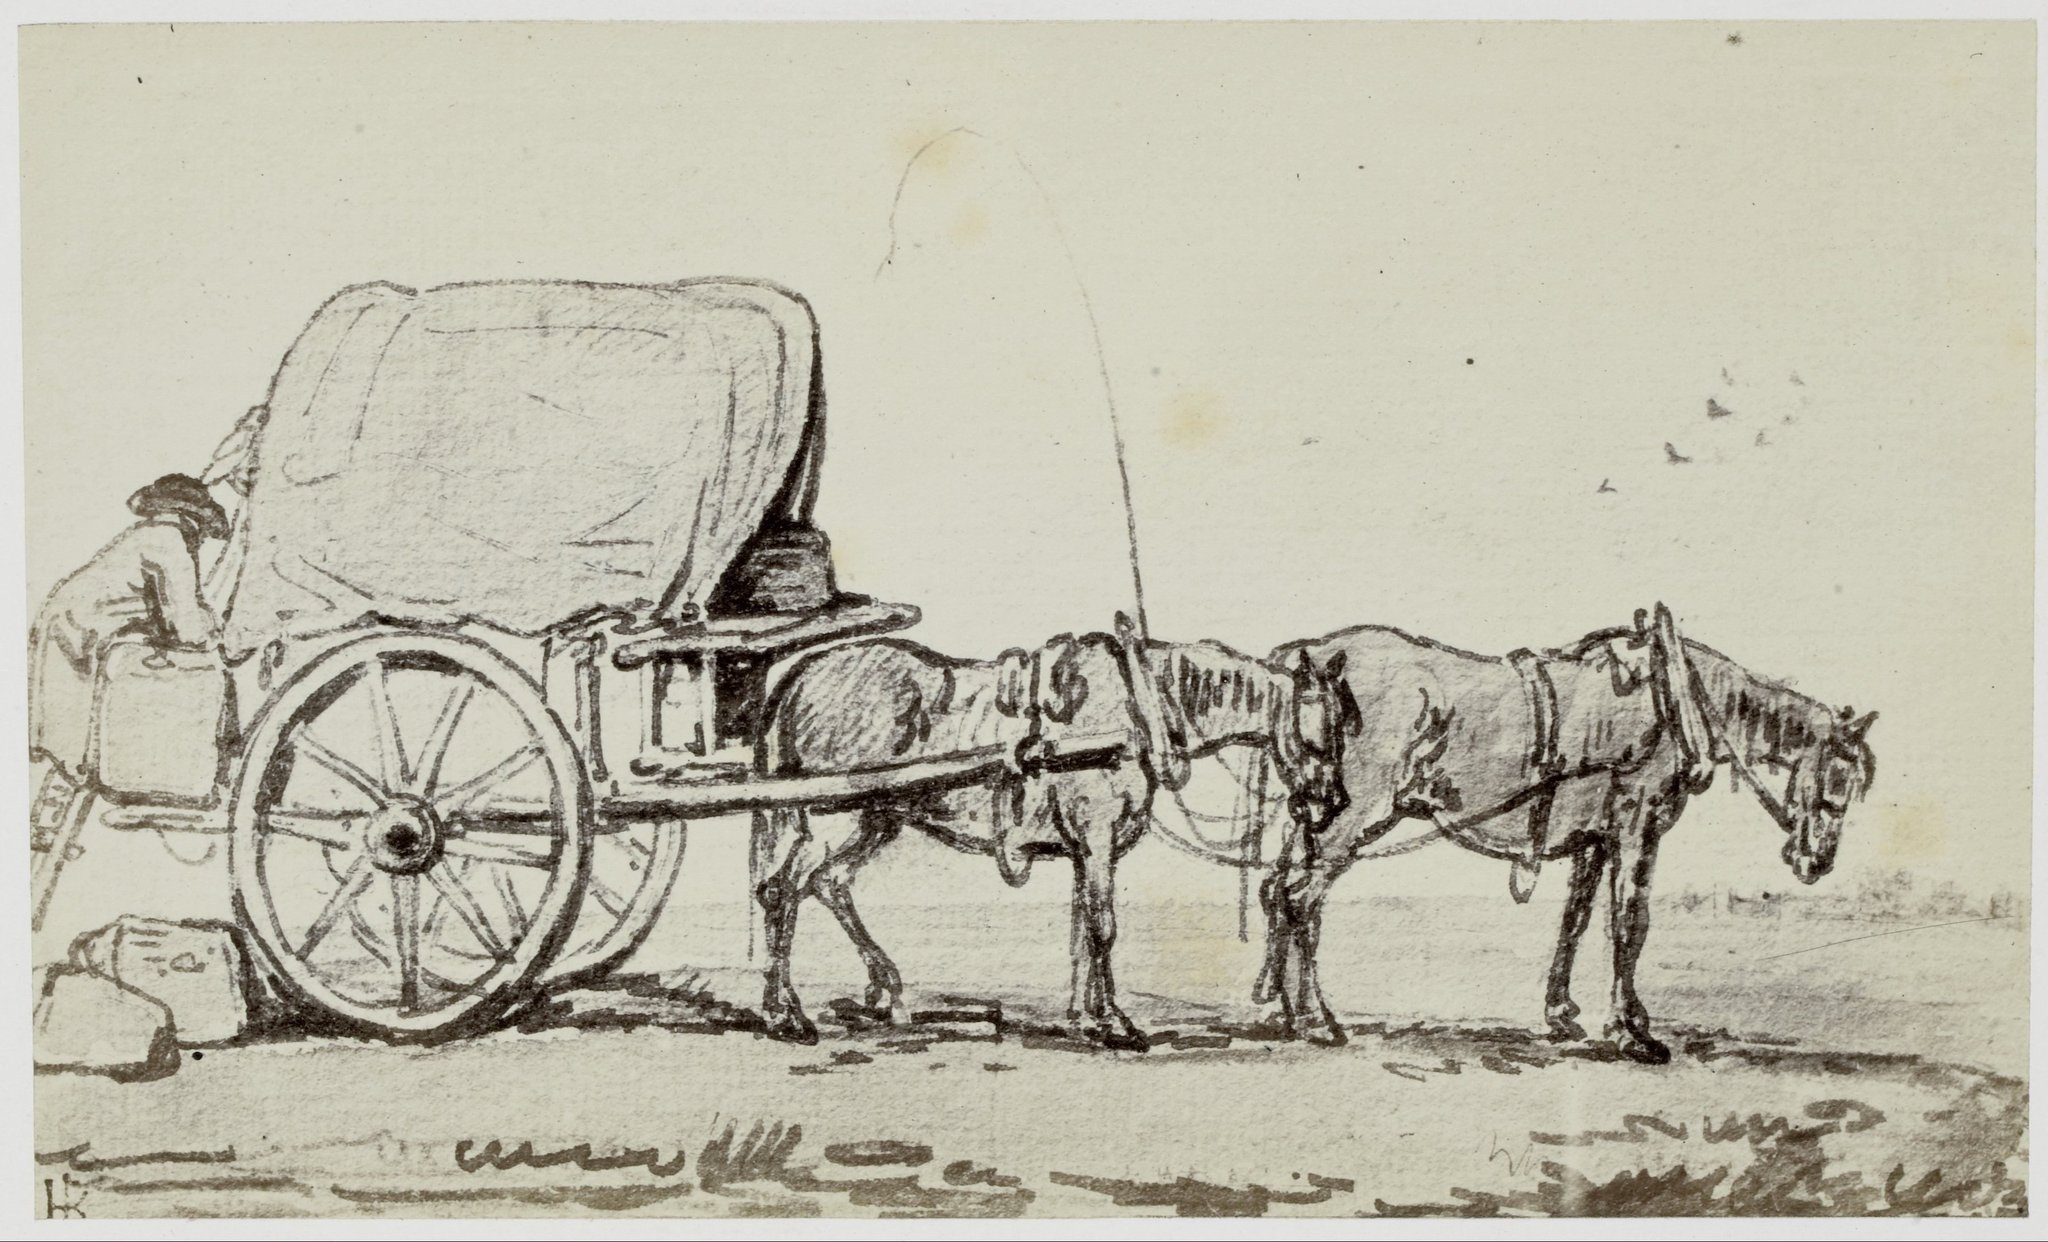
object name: photograph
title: Thomas Rowlandson, The Covered Cart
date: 1855-1858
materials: cardboard, paper, photographic support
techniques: albumen print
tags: thomas rowlandson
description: Fotoreproductie van tekening in 'The Reveley Collection of Drawings at Brynygwin', afb. 60.